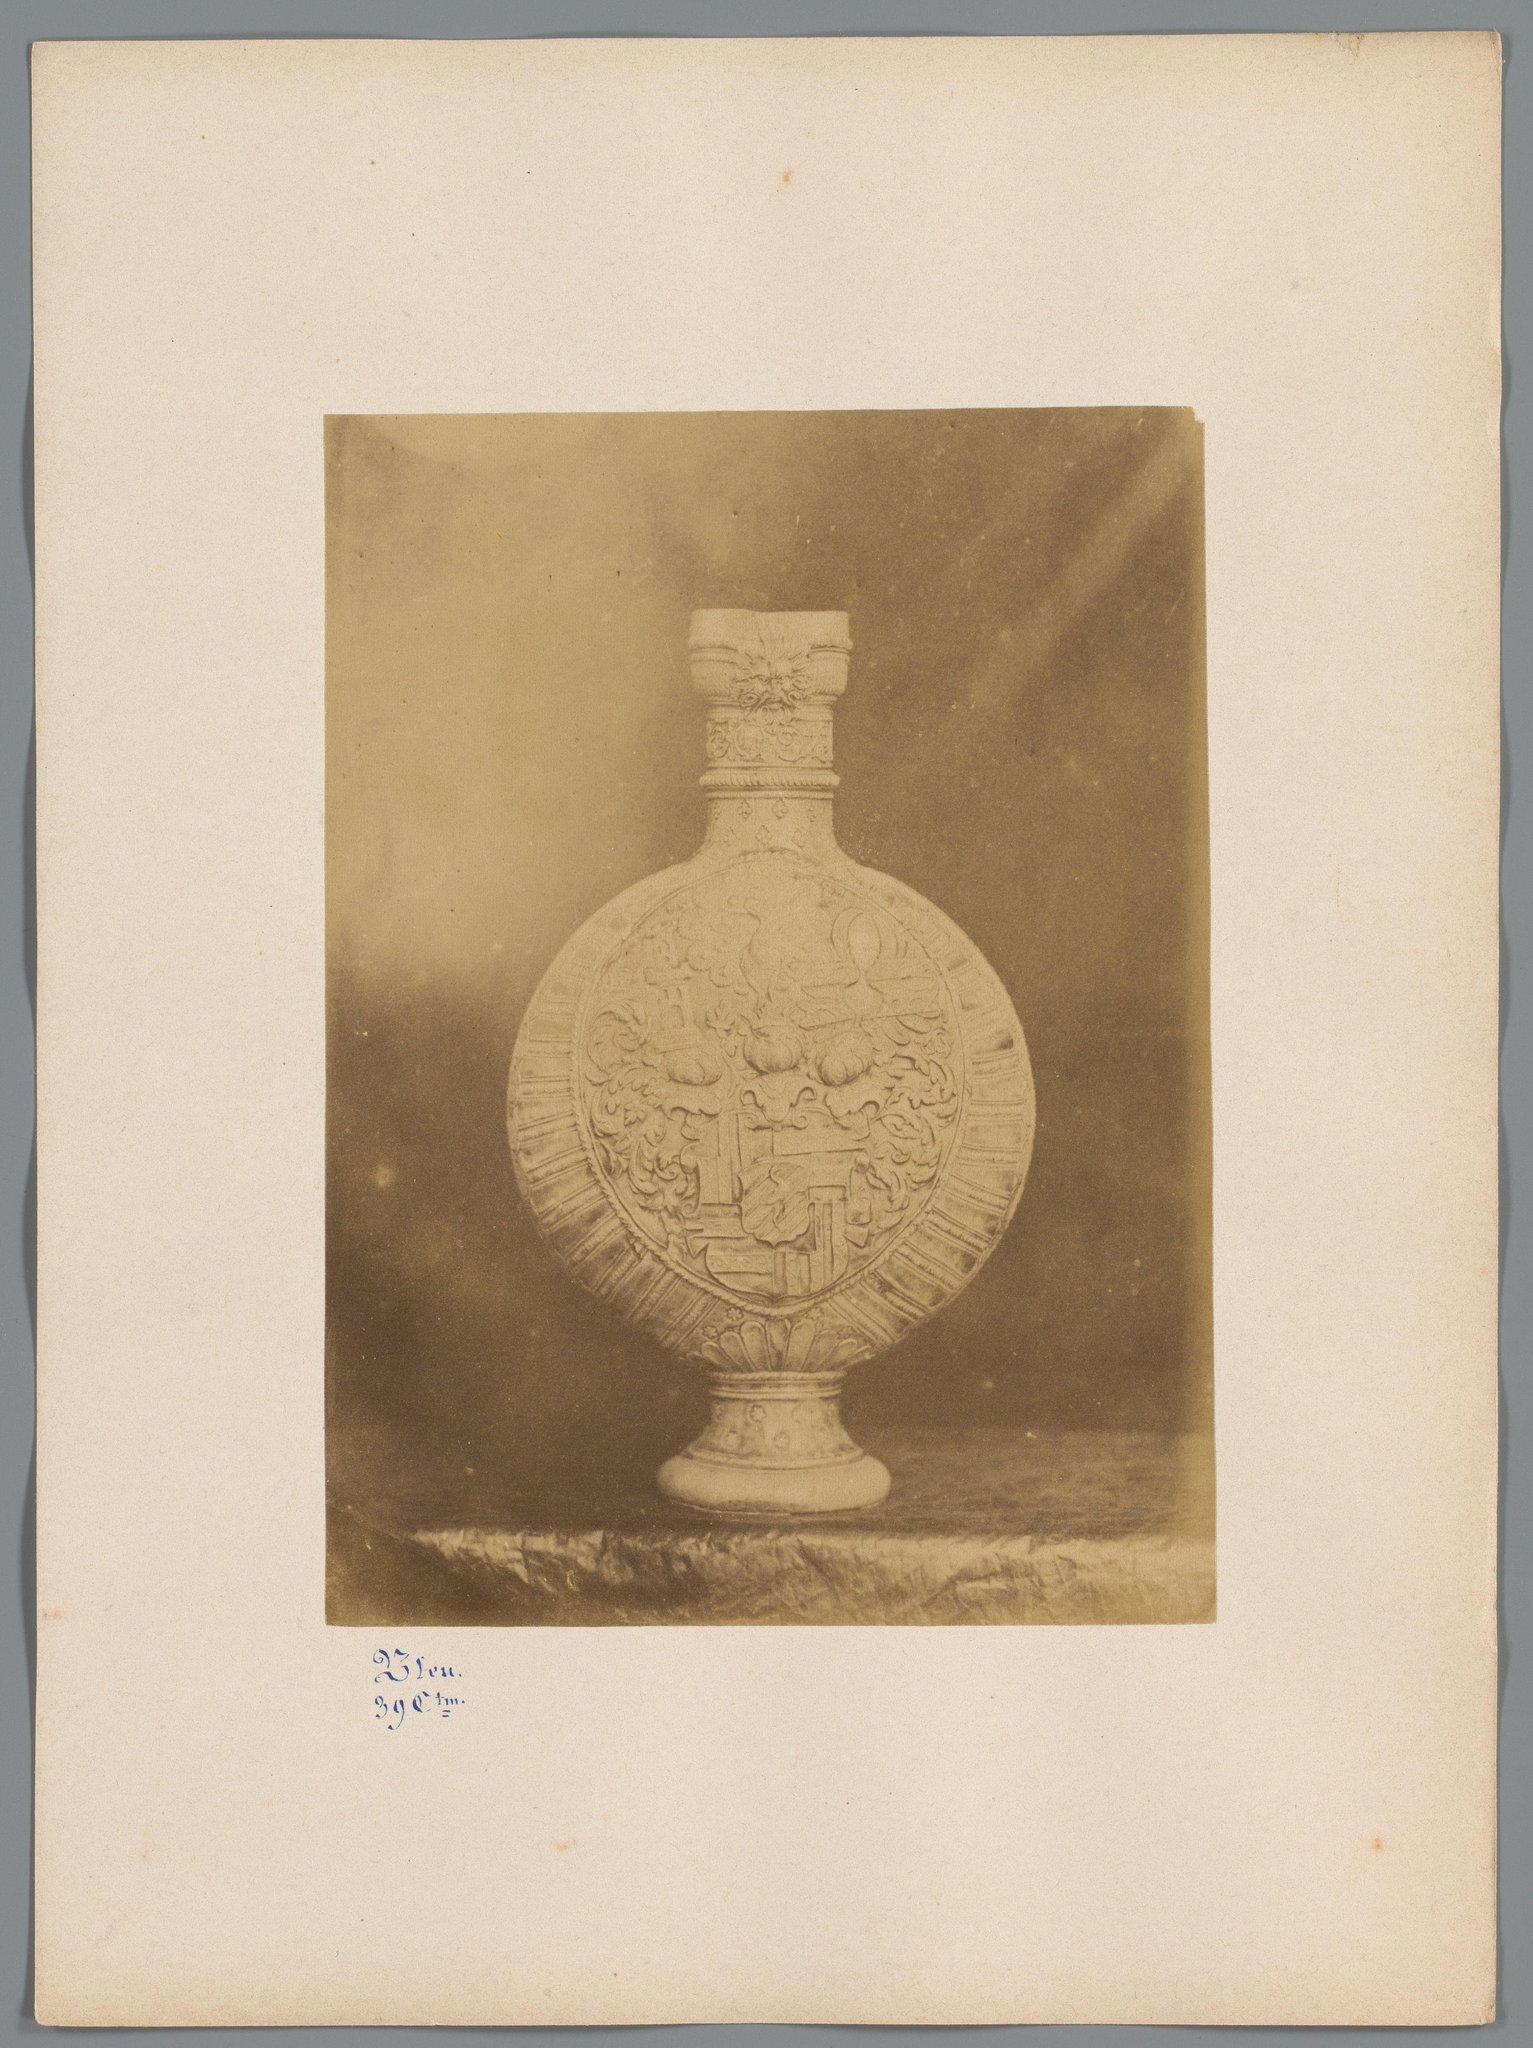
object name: photograph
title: Aardewerken vaas uit de collectie van W. de Weckherlin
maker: Anonymous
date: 1860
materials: paper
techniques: albumen print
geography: the hague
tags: container of ceramics: jar, jug, pot, vase, the hague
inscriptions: inscription: ‘Bleu./ 39 Ctm.’